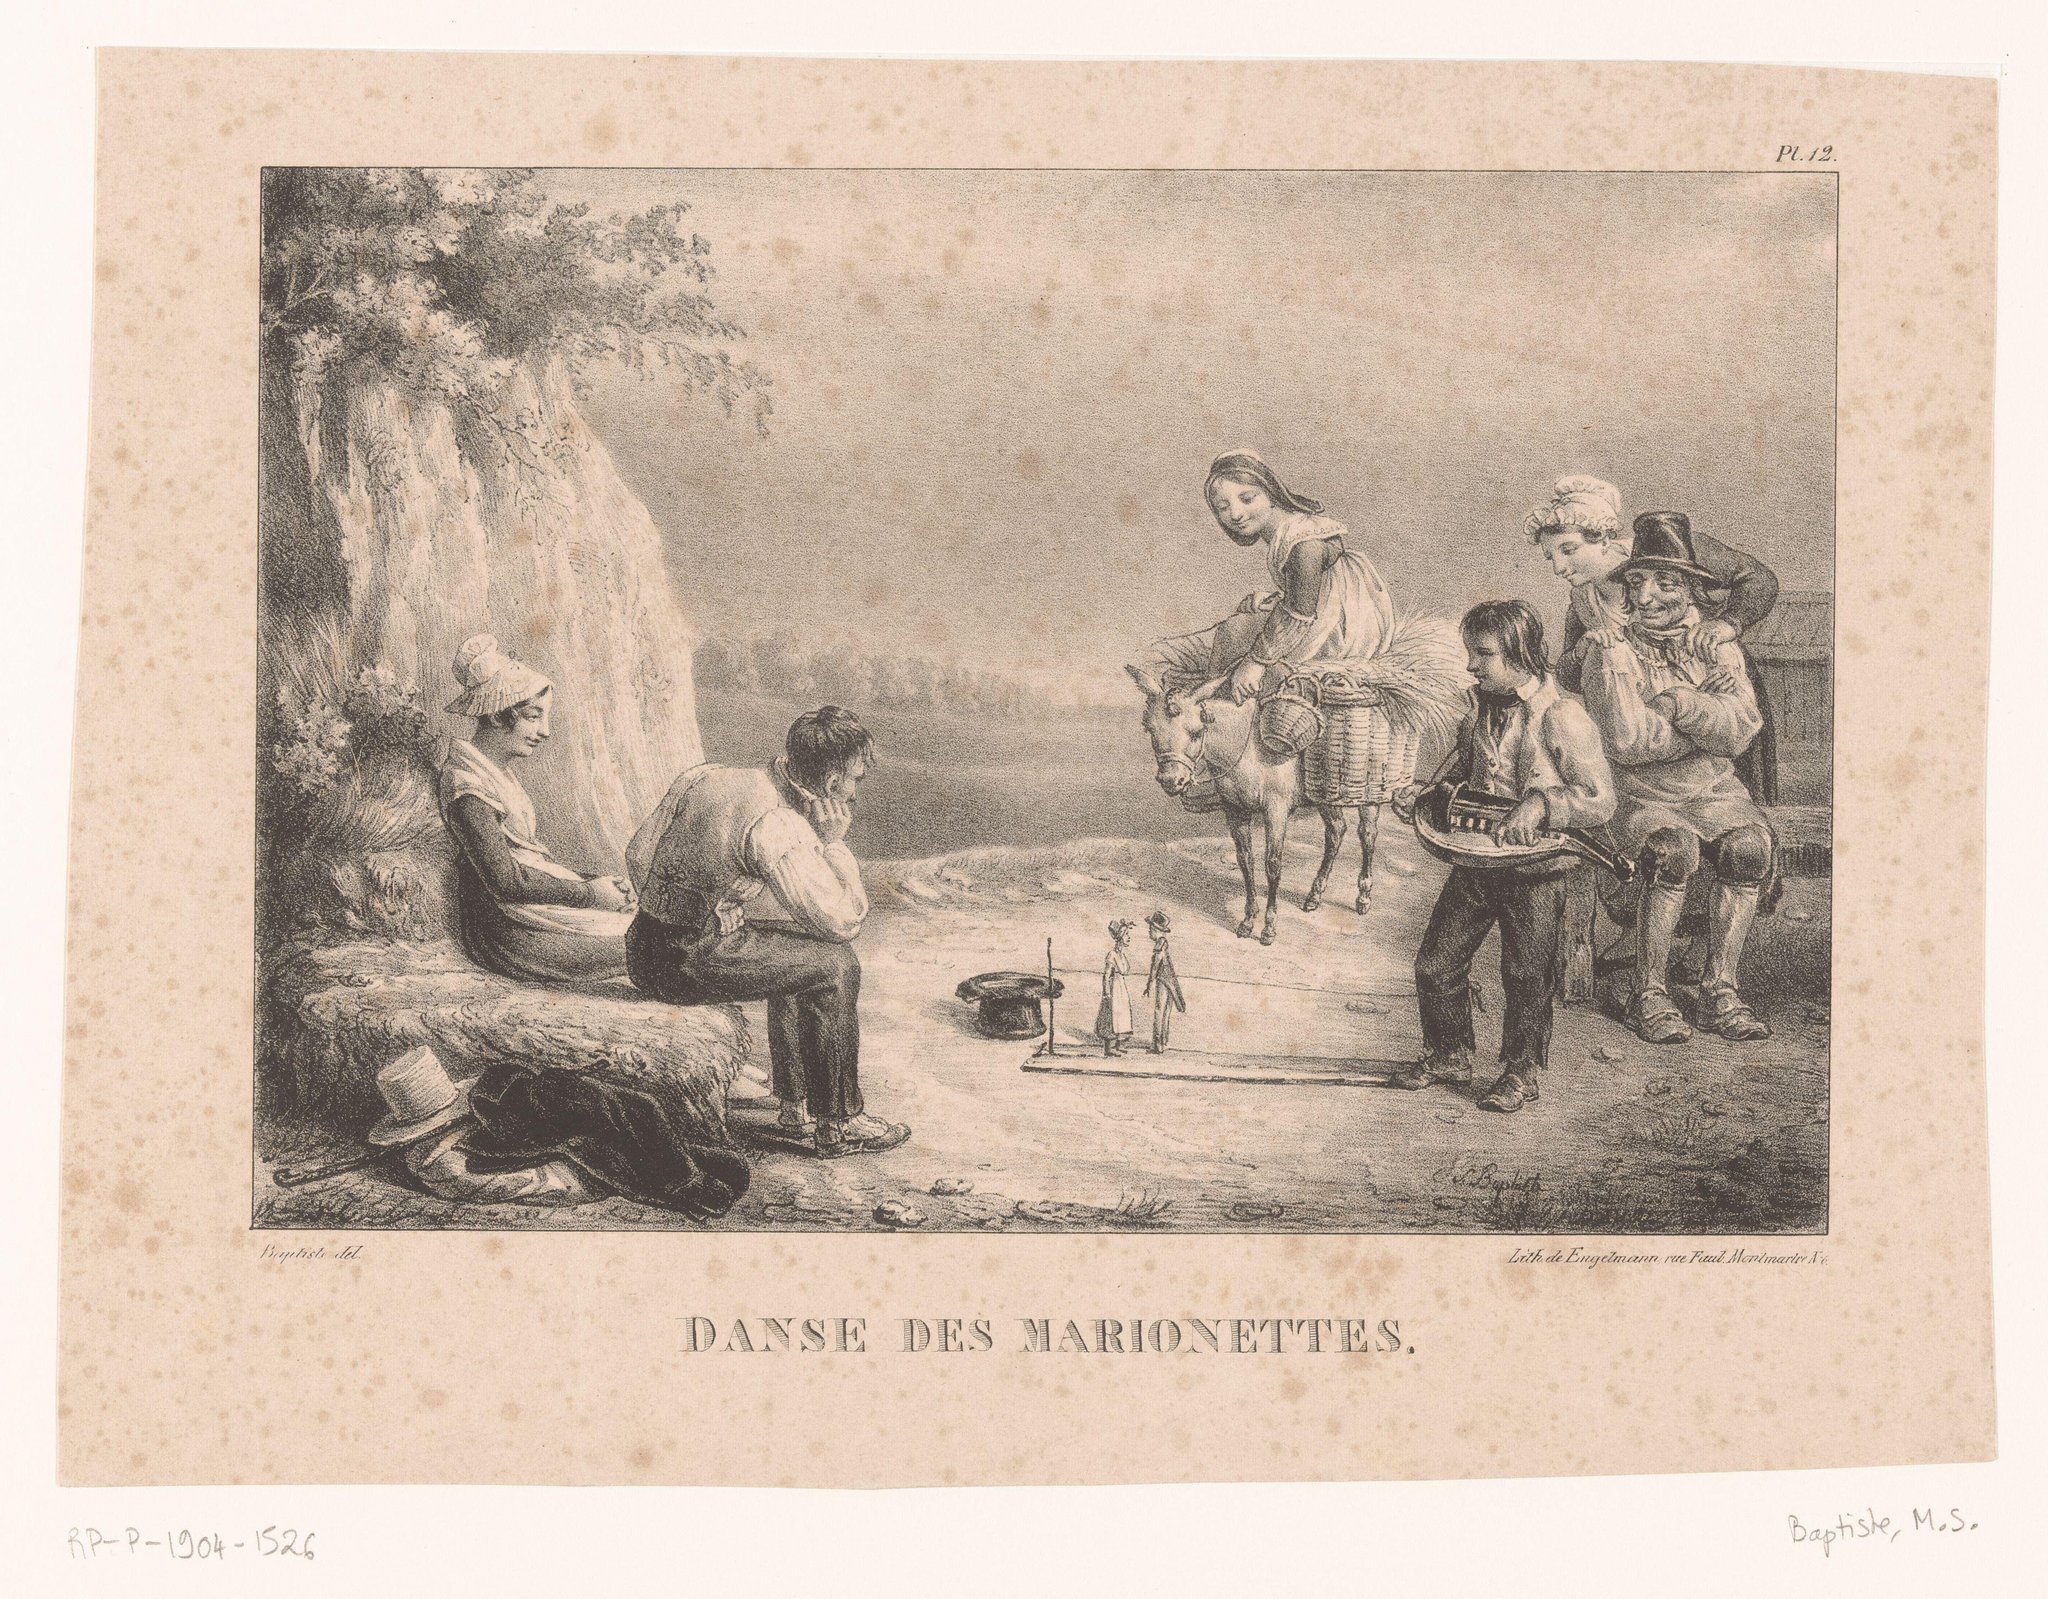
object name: print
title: Jongen met draailier geeft een marionettenvoorstelling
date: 1822-1839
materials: paper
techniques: lithograph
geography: paris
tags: hurdy-gurdy player - cc - out of doors, puppet and marionette show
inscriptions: collector's mark: Lugt 2228a